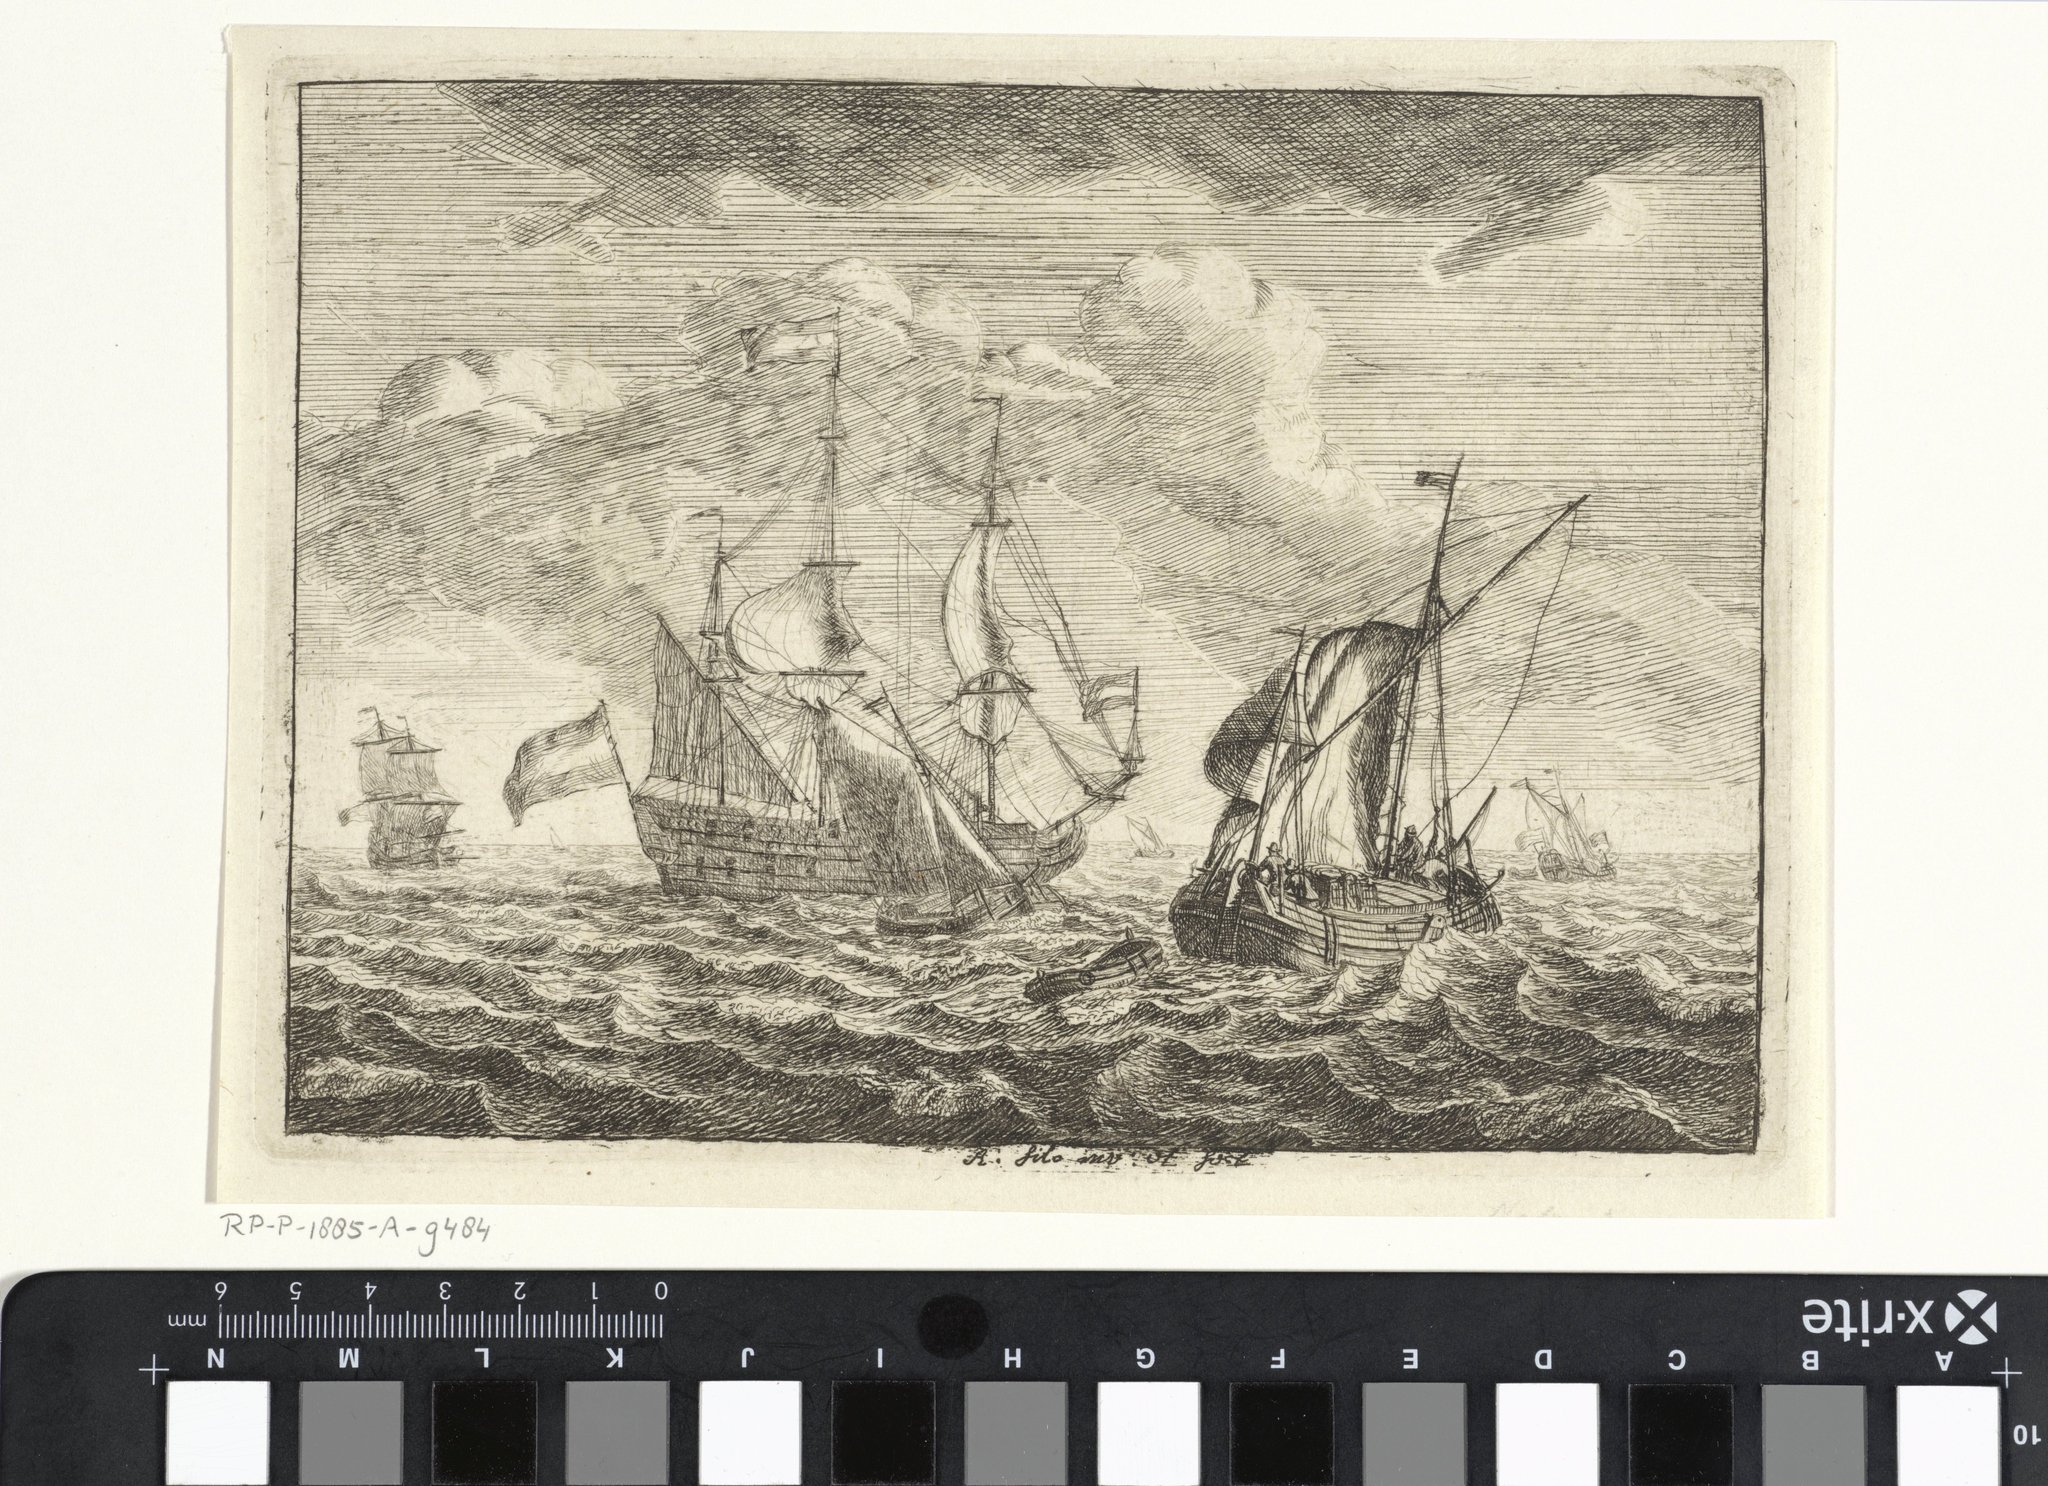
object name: print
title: Zeegezicht met twee- en driemasters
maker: adam silo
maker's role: print maker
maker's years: 1674-1760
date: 1689-1760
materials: paper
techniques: engraving, etching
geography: amsterdam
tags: sea (seascape)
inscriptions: collector's mark: Lugt 2228